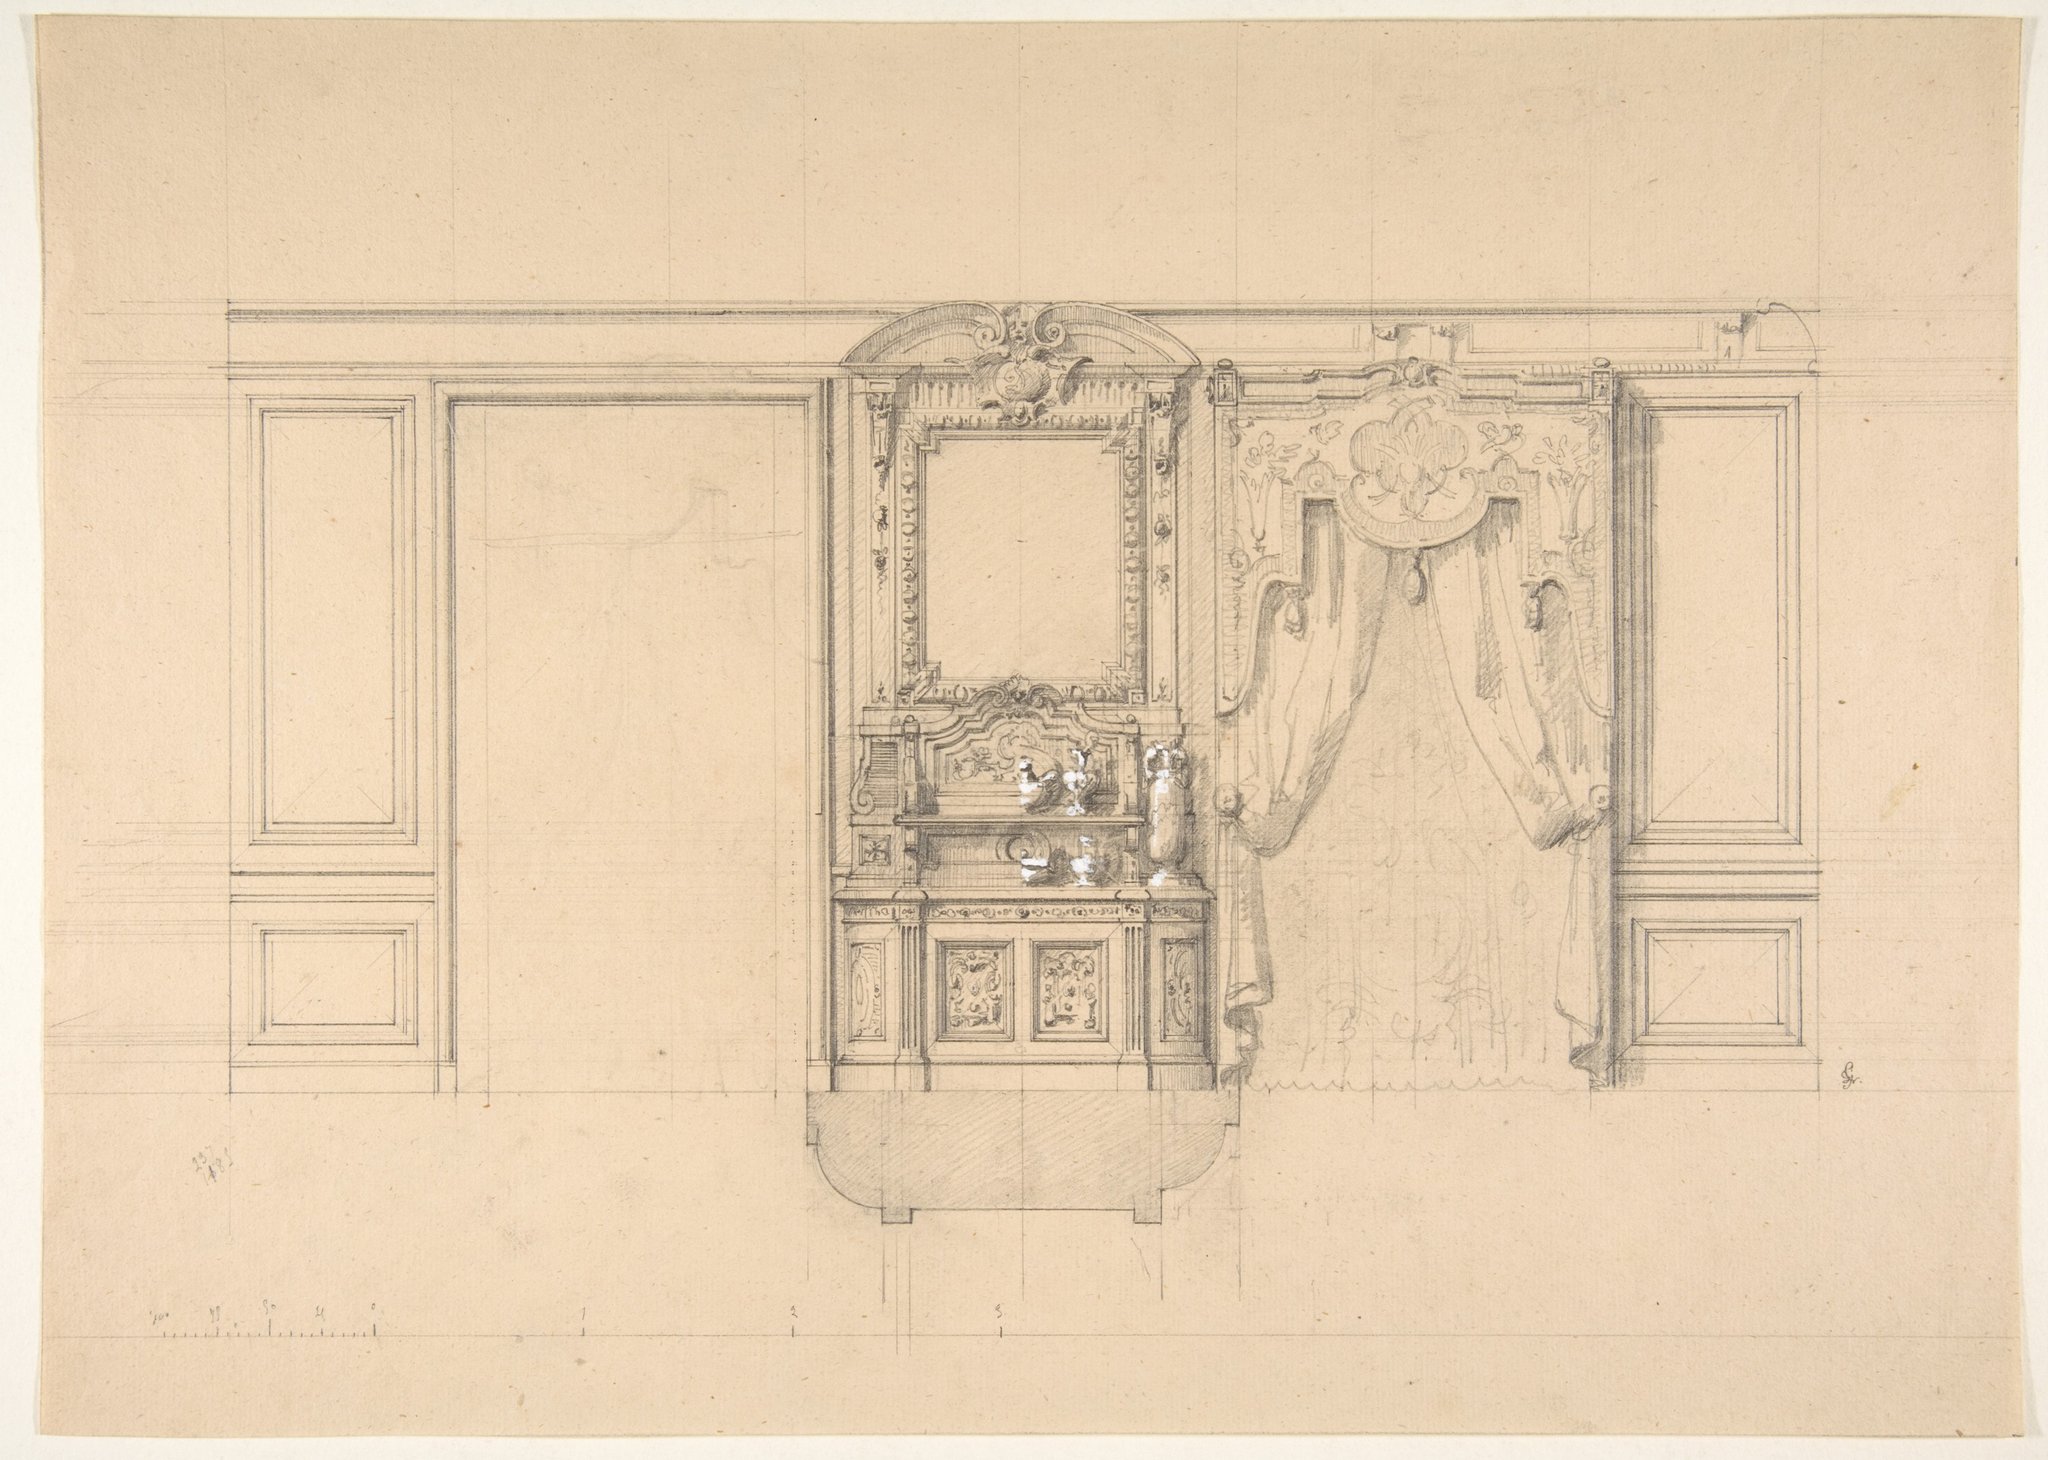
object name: drawing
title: Elevation of a dining room with a carved buffet and window draperies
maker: jules-edmond-charles lachaise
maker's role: artist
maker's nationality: french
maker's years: 1897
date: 1801-1900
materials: graphite, paper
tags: architecture,dining rooms